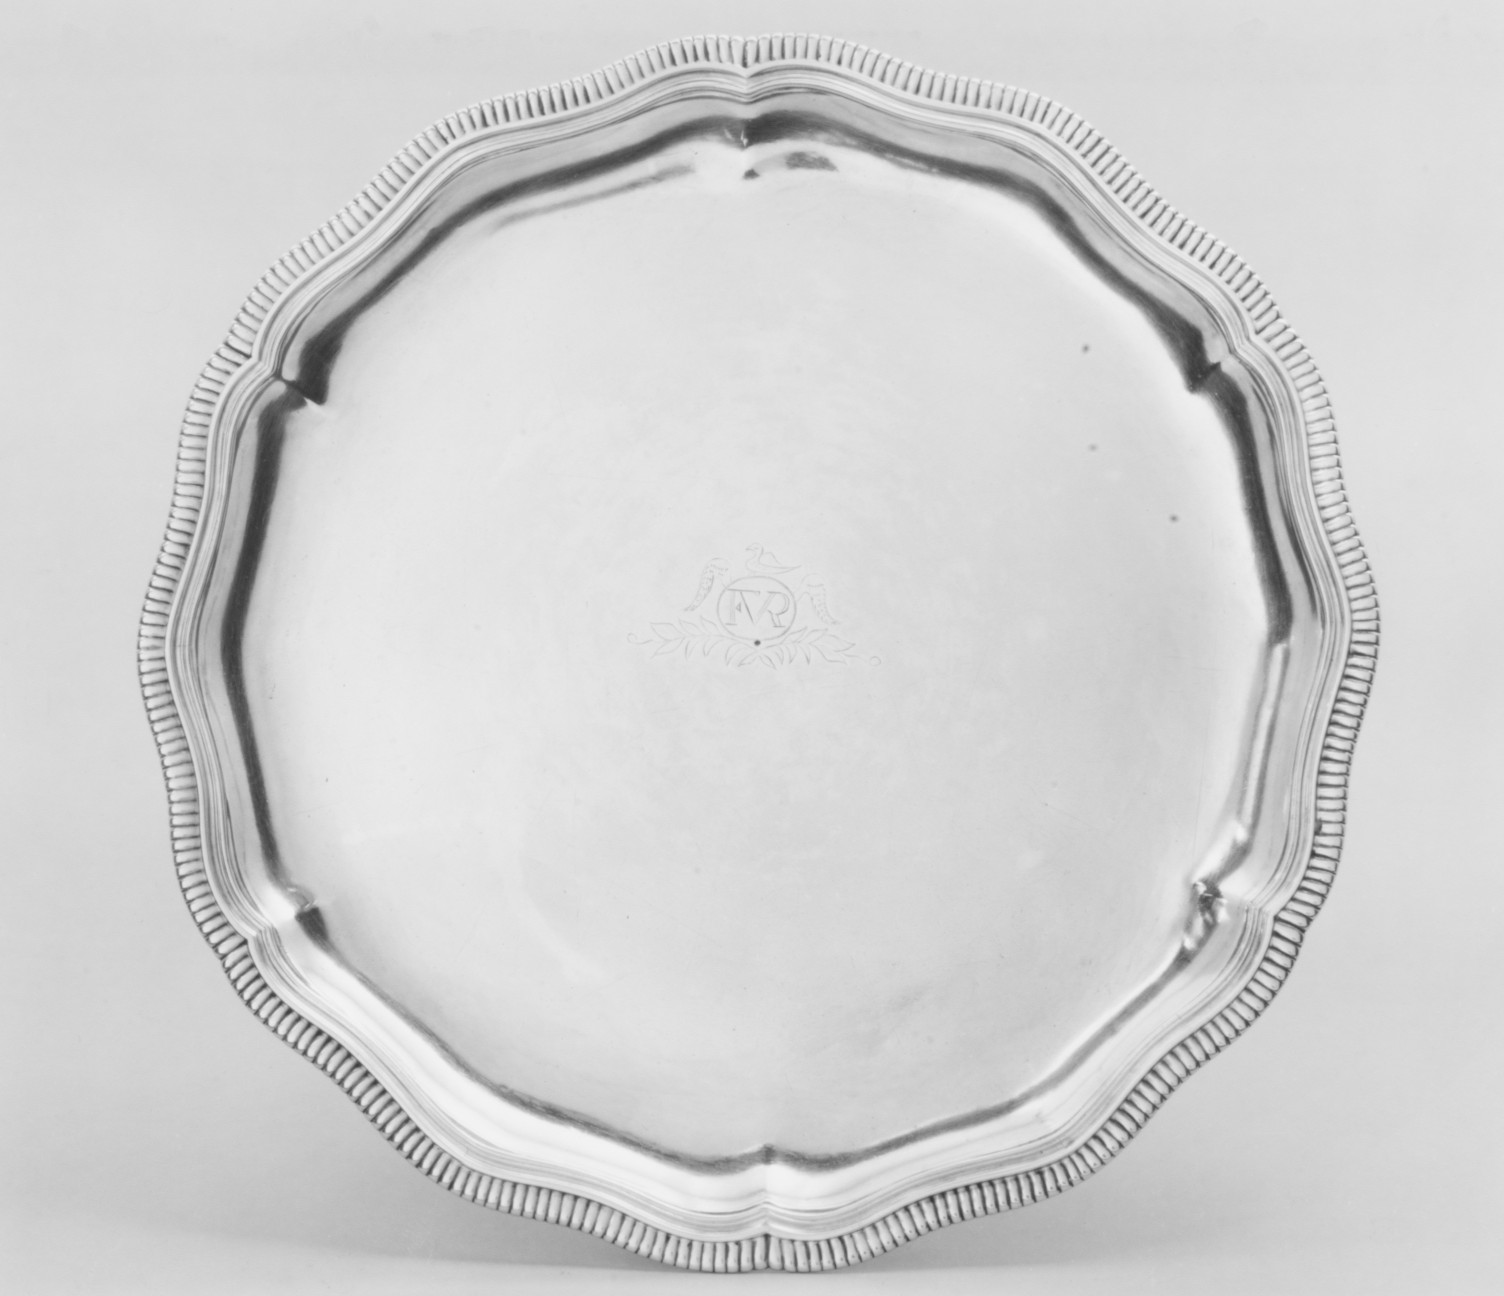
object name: salver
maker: d.i.i.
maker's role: maker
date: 1750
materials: silver